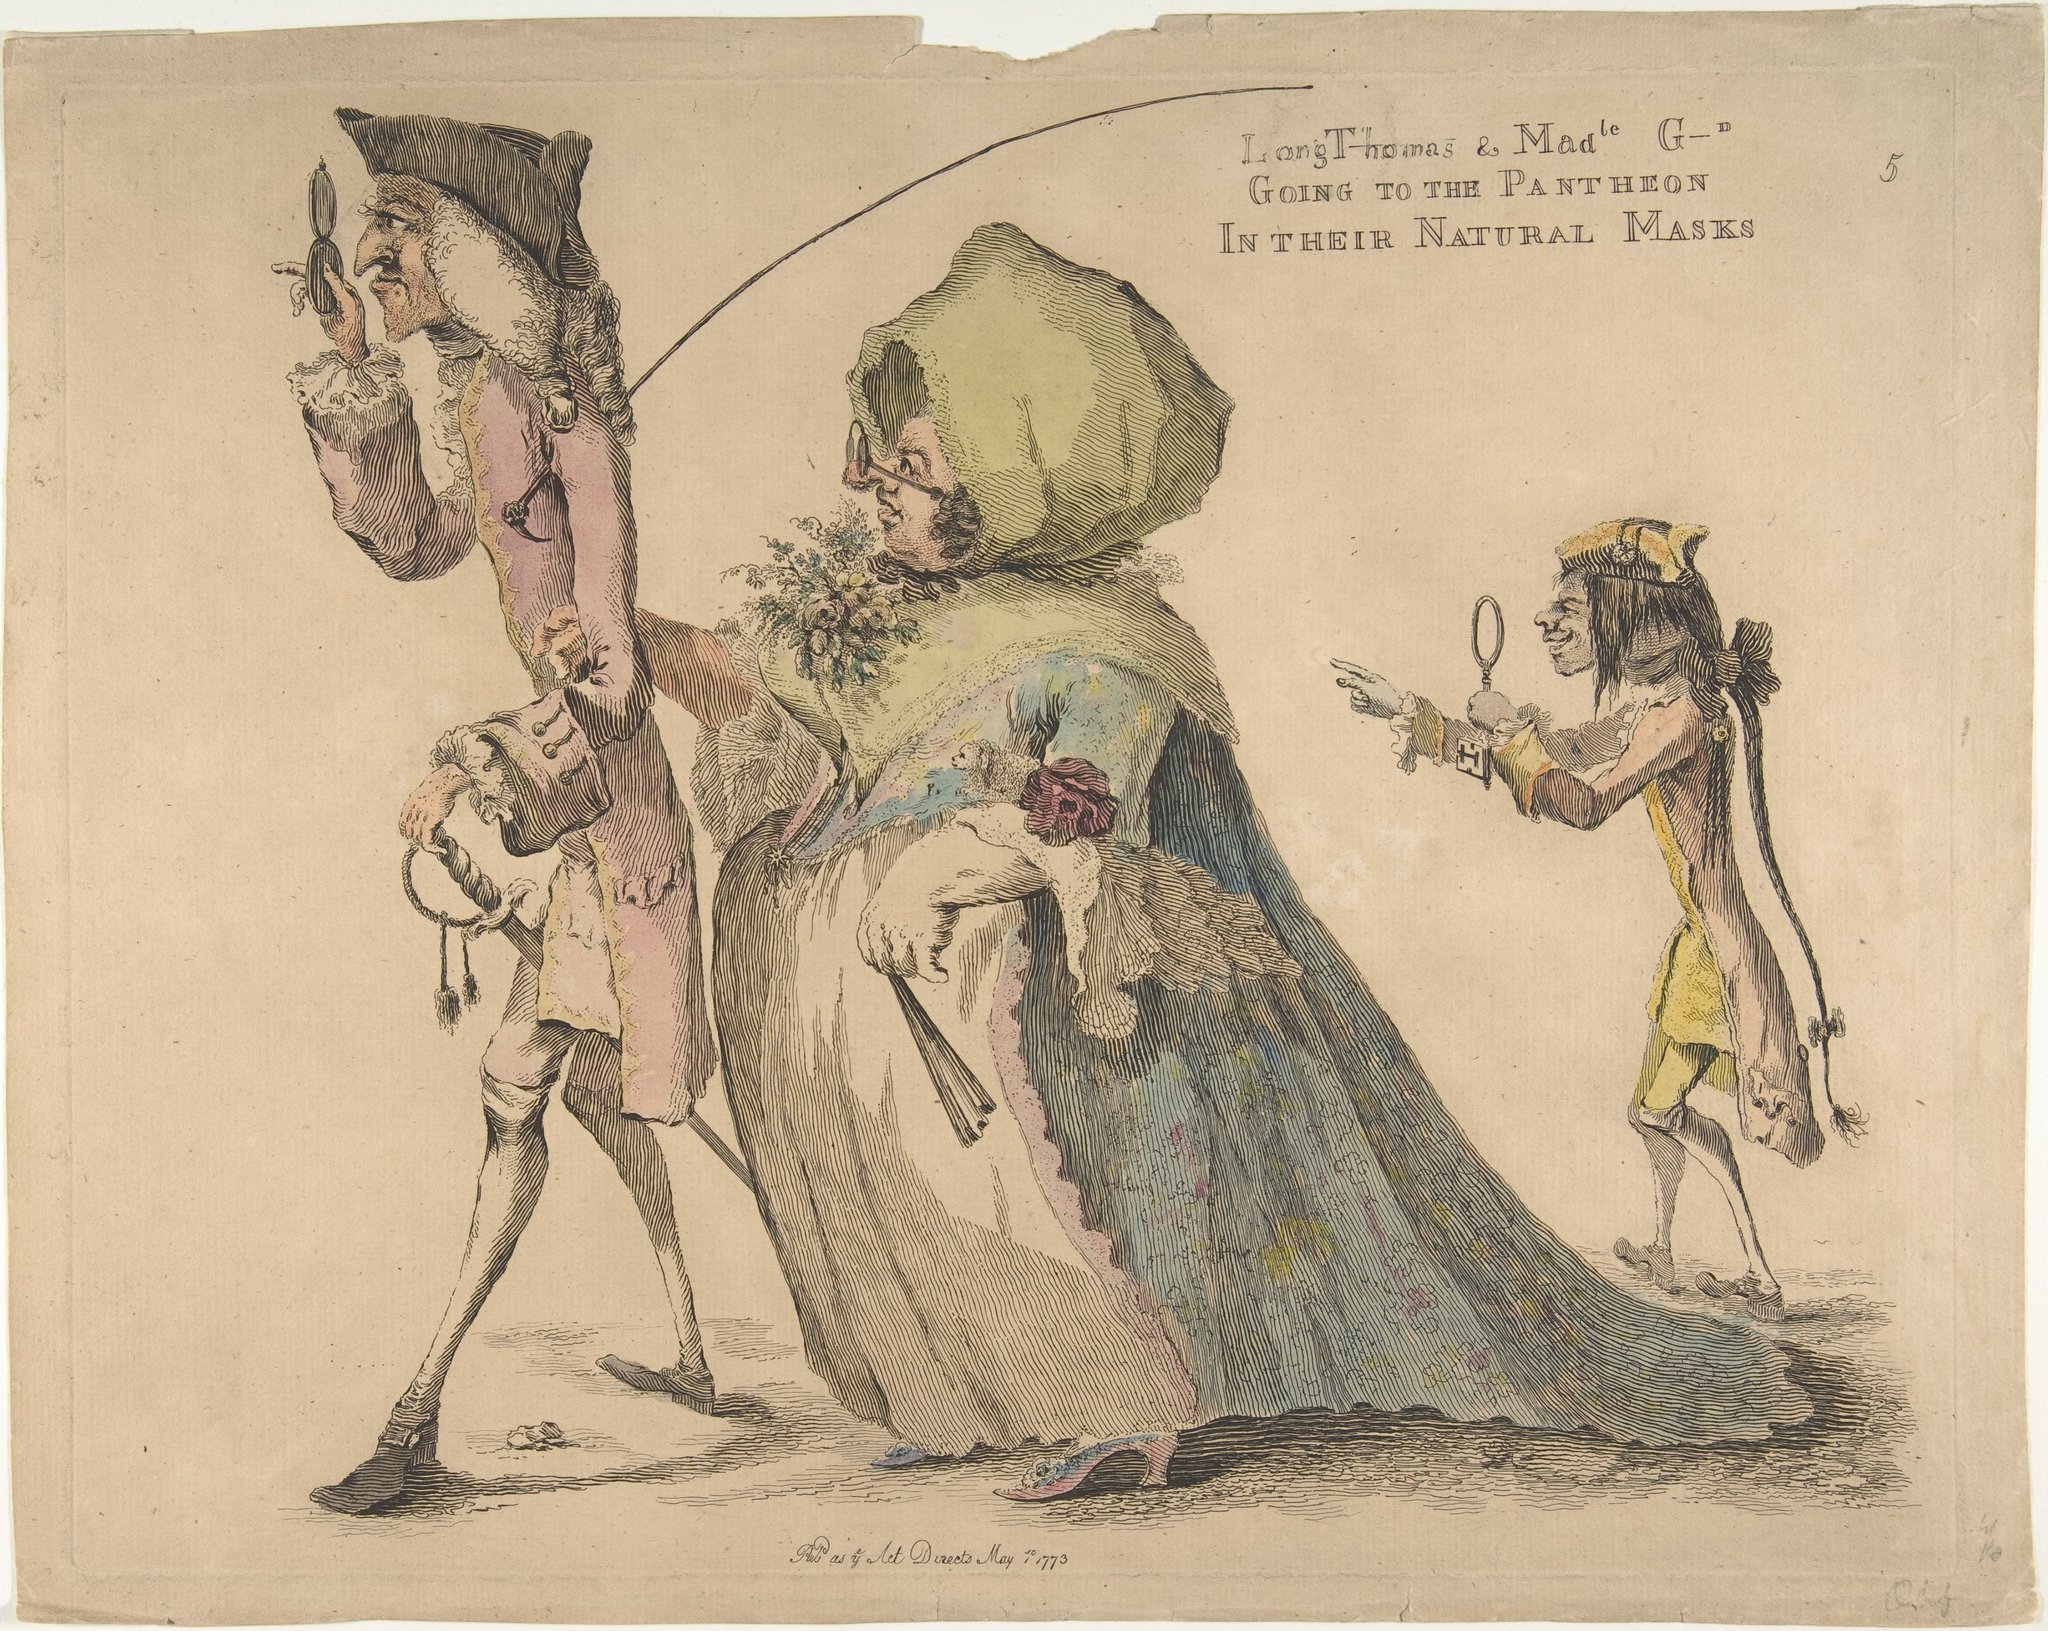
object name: print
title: Long Thomas and Mad-le G-d Going to the Pantheon in Their Natural Masks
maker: william austin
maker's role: artist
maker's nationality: british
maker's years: 1721-1820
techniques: etching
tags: men,women,caricature